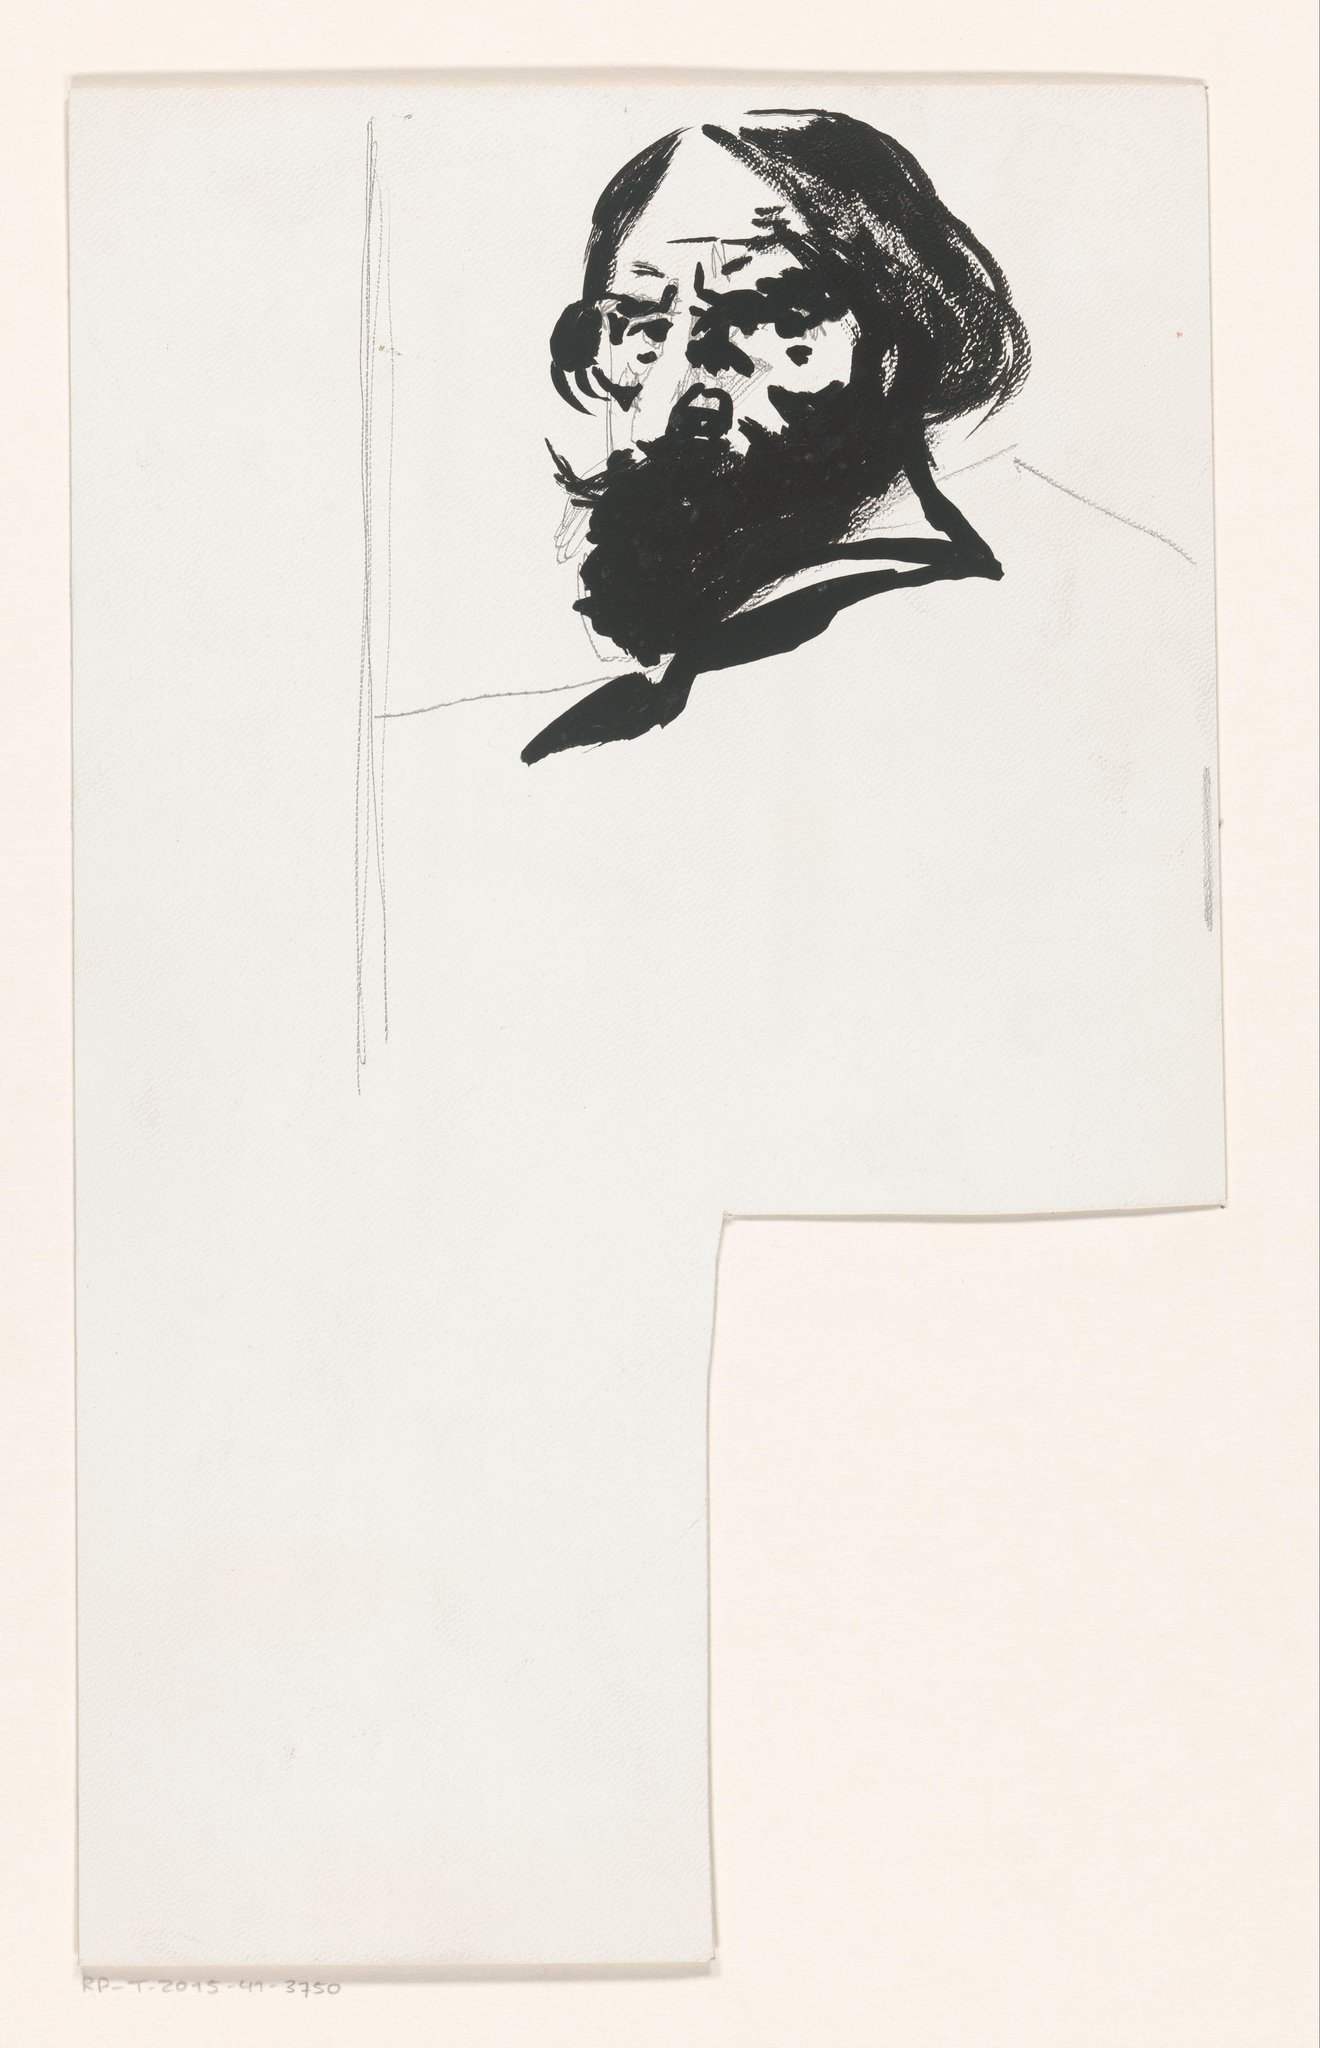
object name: drawing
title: Bandontwerp voor: N.S. Ljeskow, De onsterfelijke, 1965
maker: karel thole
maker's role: painter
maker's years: 1914-2000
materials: cardboard, ink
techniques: brush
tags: head (human), beard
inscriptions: collector's mark: Lugt 2228a, factory mark: ‘DISTRIBUTED BY/ WINSOR & NEWTON LTD./ WEALDSTONE HARROW/ MIDDLESEX ENGLAND/ MADE IN ENGLAND’